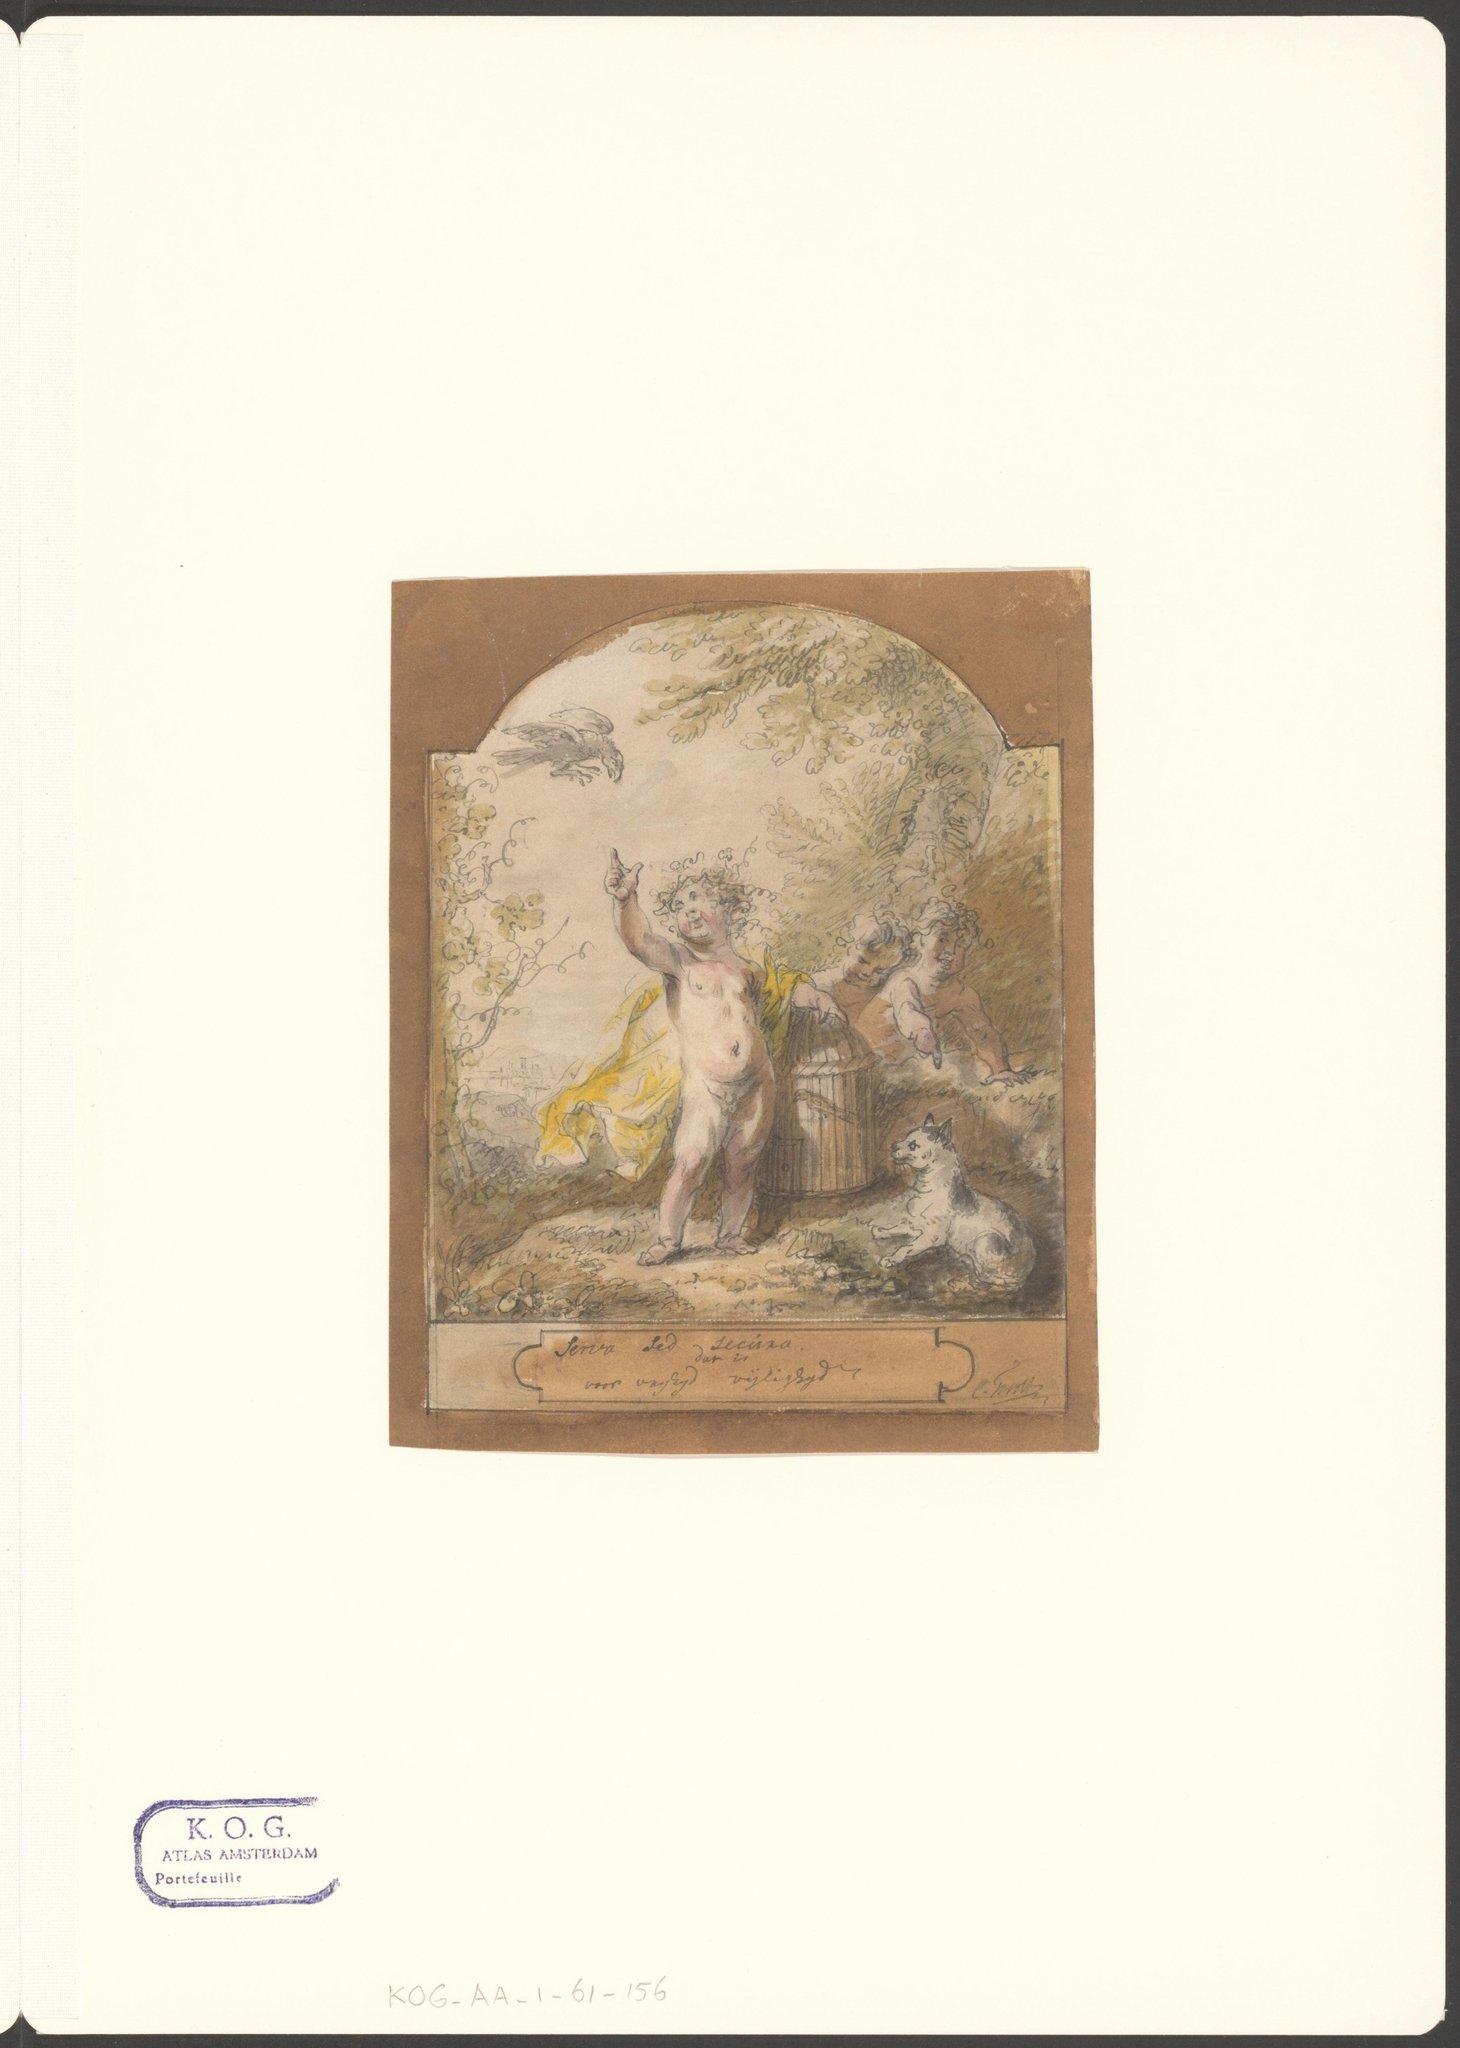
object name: drawing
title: Amor met gekooide vogel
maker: cornelis troost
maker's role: draughtsman, painter, print maker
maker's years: 1696-1750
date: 1712-1750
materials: ink, paper, pencil, watercolor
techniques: brush, pen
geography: amsterdam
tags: bird in a cage, cupids: 'amores', 'amoretti', 'putti'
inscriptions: inscription: ‘Serva sed secina / dat is / voor vryhyd vijlighyd’, signature: ‘C.Troost’, collector's mark: Lugt 1641b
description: Onderwerpsrubriek binnen de Atlas Amsterdam: Teekenacademie - Kon. Academie van Beeldende Kunsten - Schildersateliers.